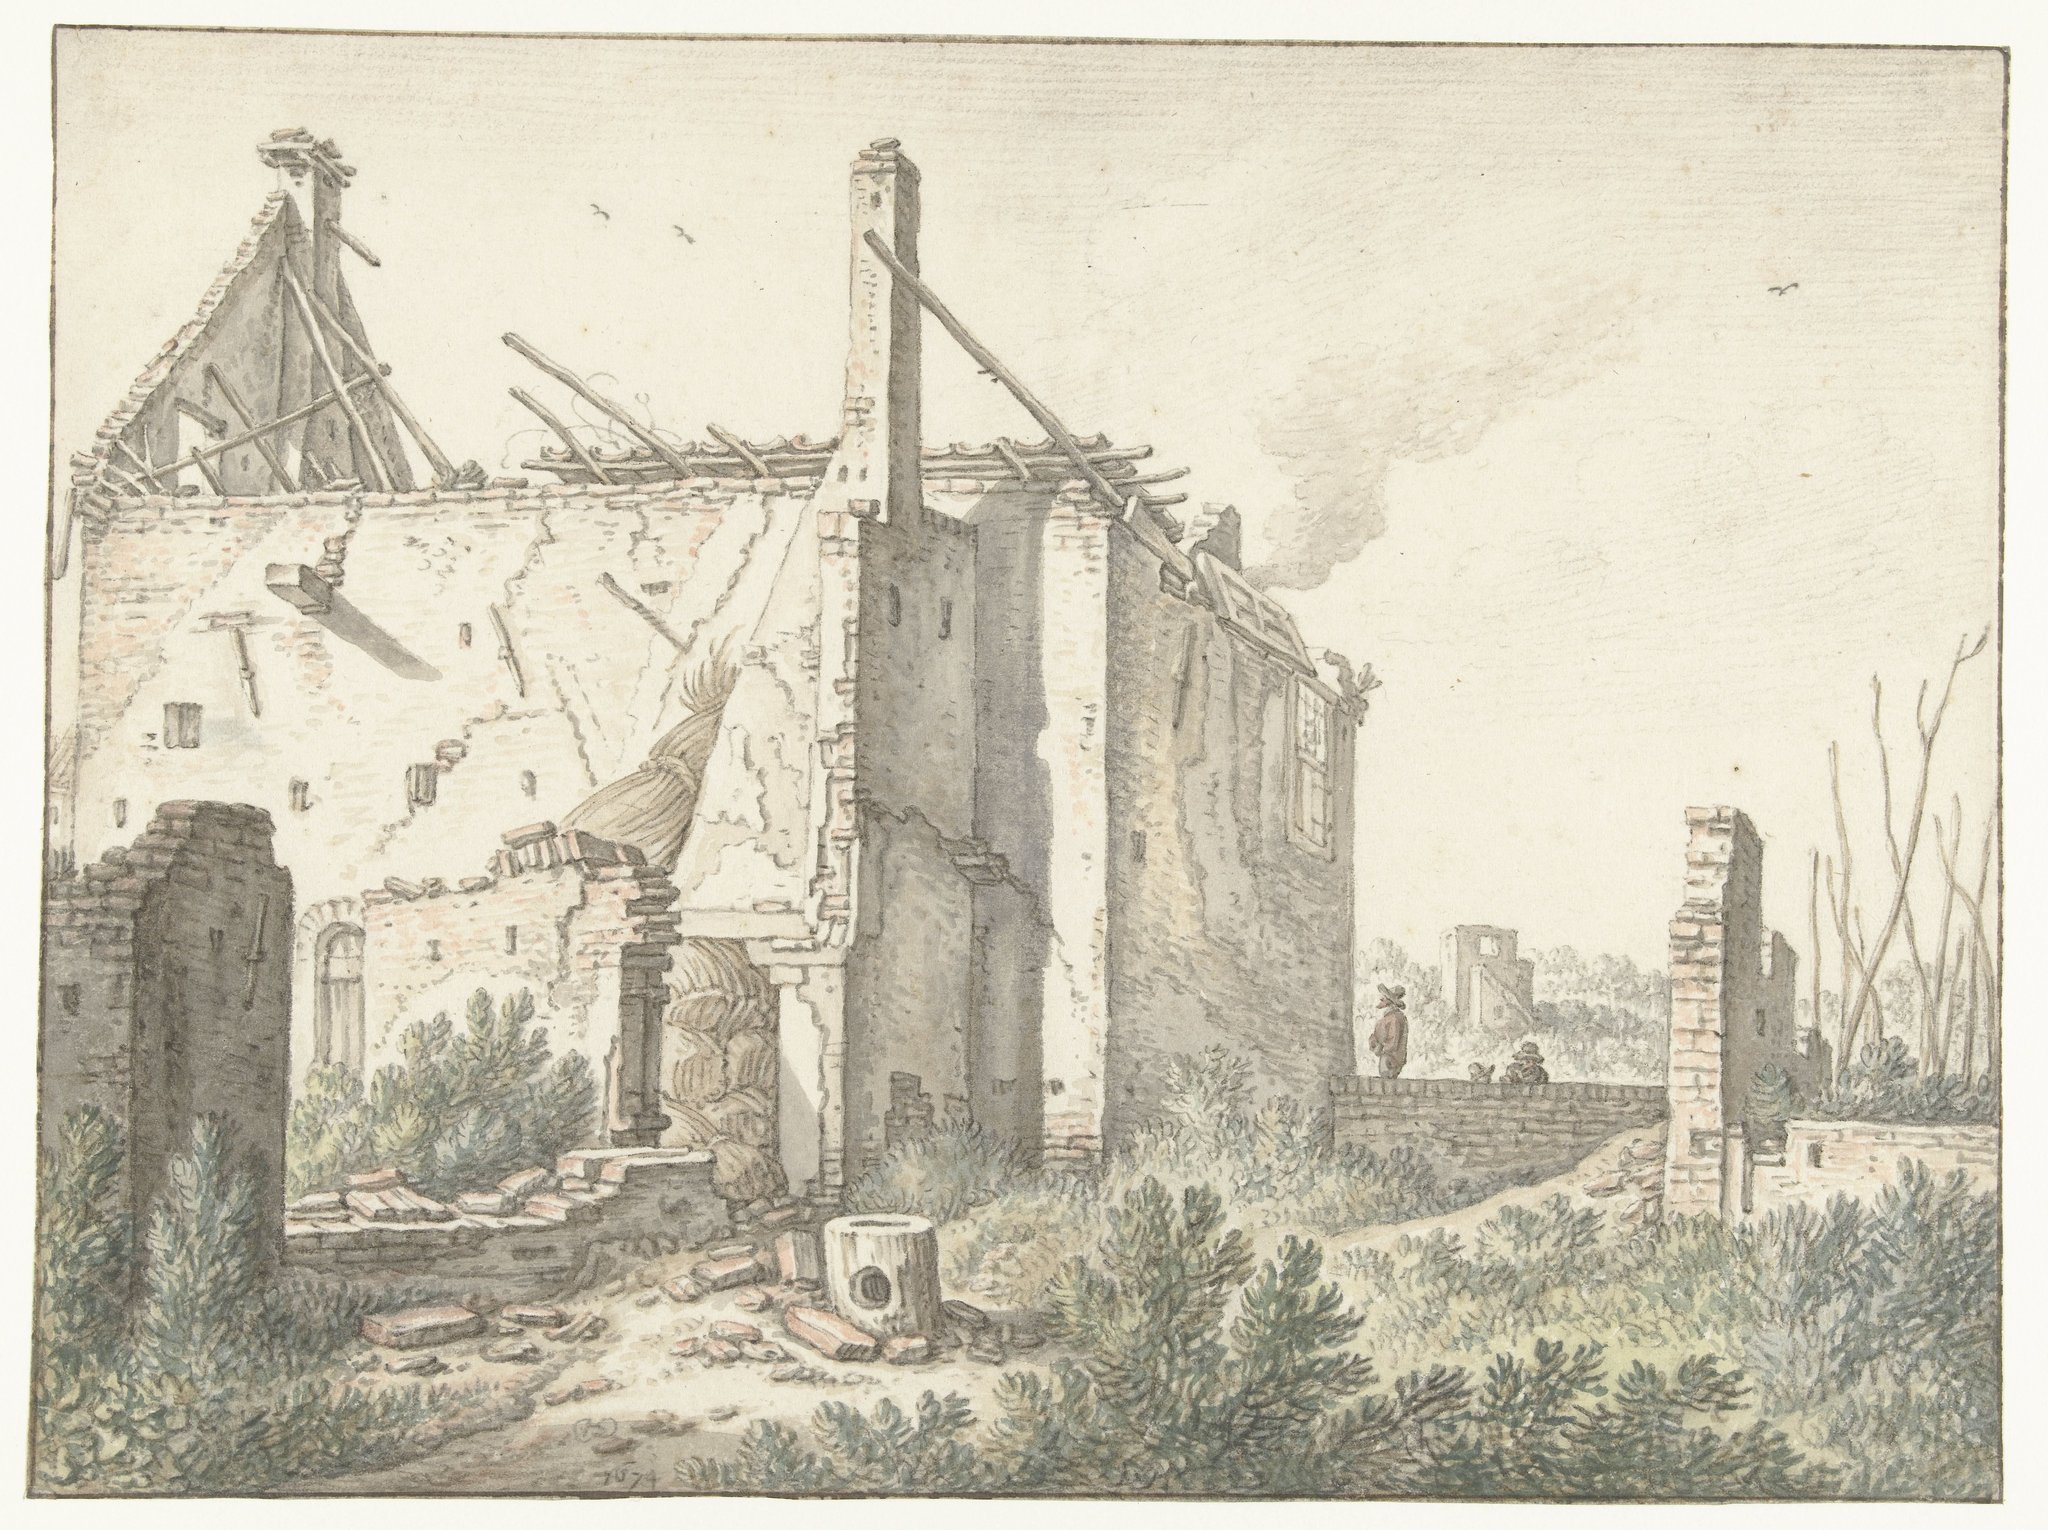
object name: drawing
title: Ruïne van een huis in Utrecht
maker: herman saftleven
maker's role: draughtsman, painter, print maker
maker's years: 1609-1685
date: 1674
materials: chalk, paper, watercolor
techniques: brush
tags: ruin of a building ~ architecture, rural housing, e.g. country-house, villa, cottage, utrecht